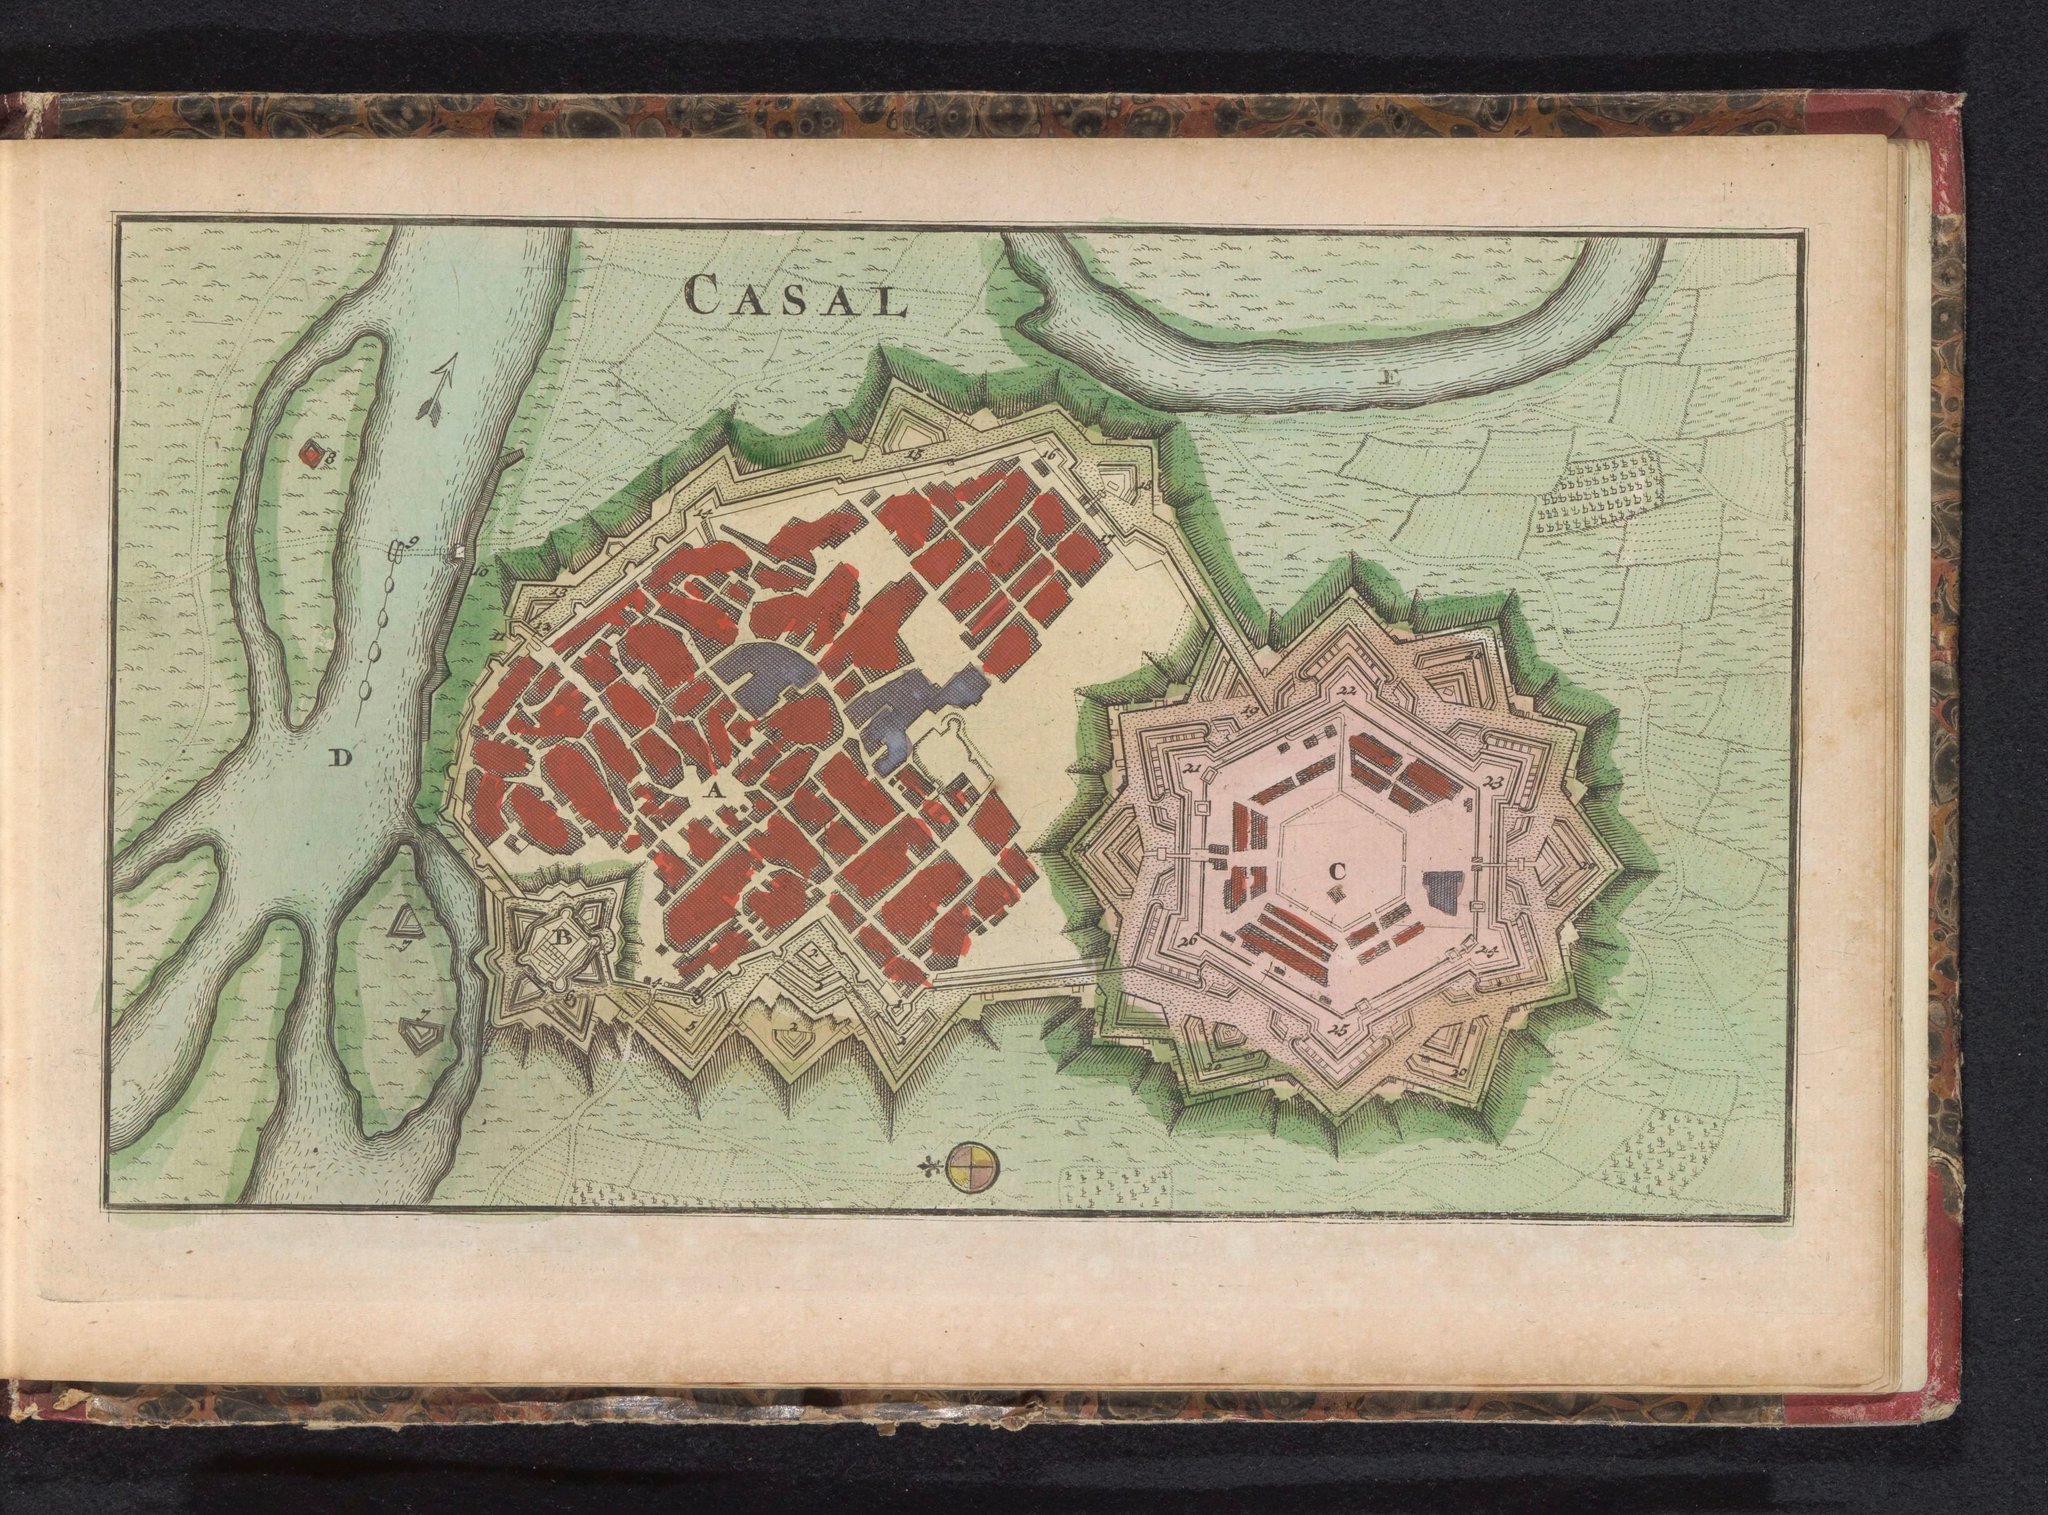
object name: map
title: Casal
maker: Anonymous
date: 1700-1702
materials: paper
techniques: engraving, etching, hand coloring, lacquer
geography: northern netherlands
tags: fortress, maps of cities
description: Plattegrond van de versterkingen rond de Italiaanse stad Casale Monferrato. Onderdeel van een atlas met 223 kaarten van landen en steden en oorlogstaferelen in Europa in de periode ca. 1690-1735.